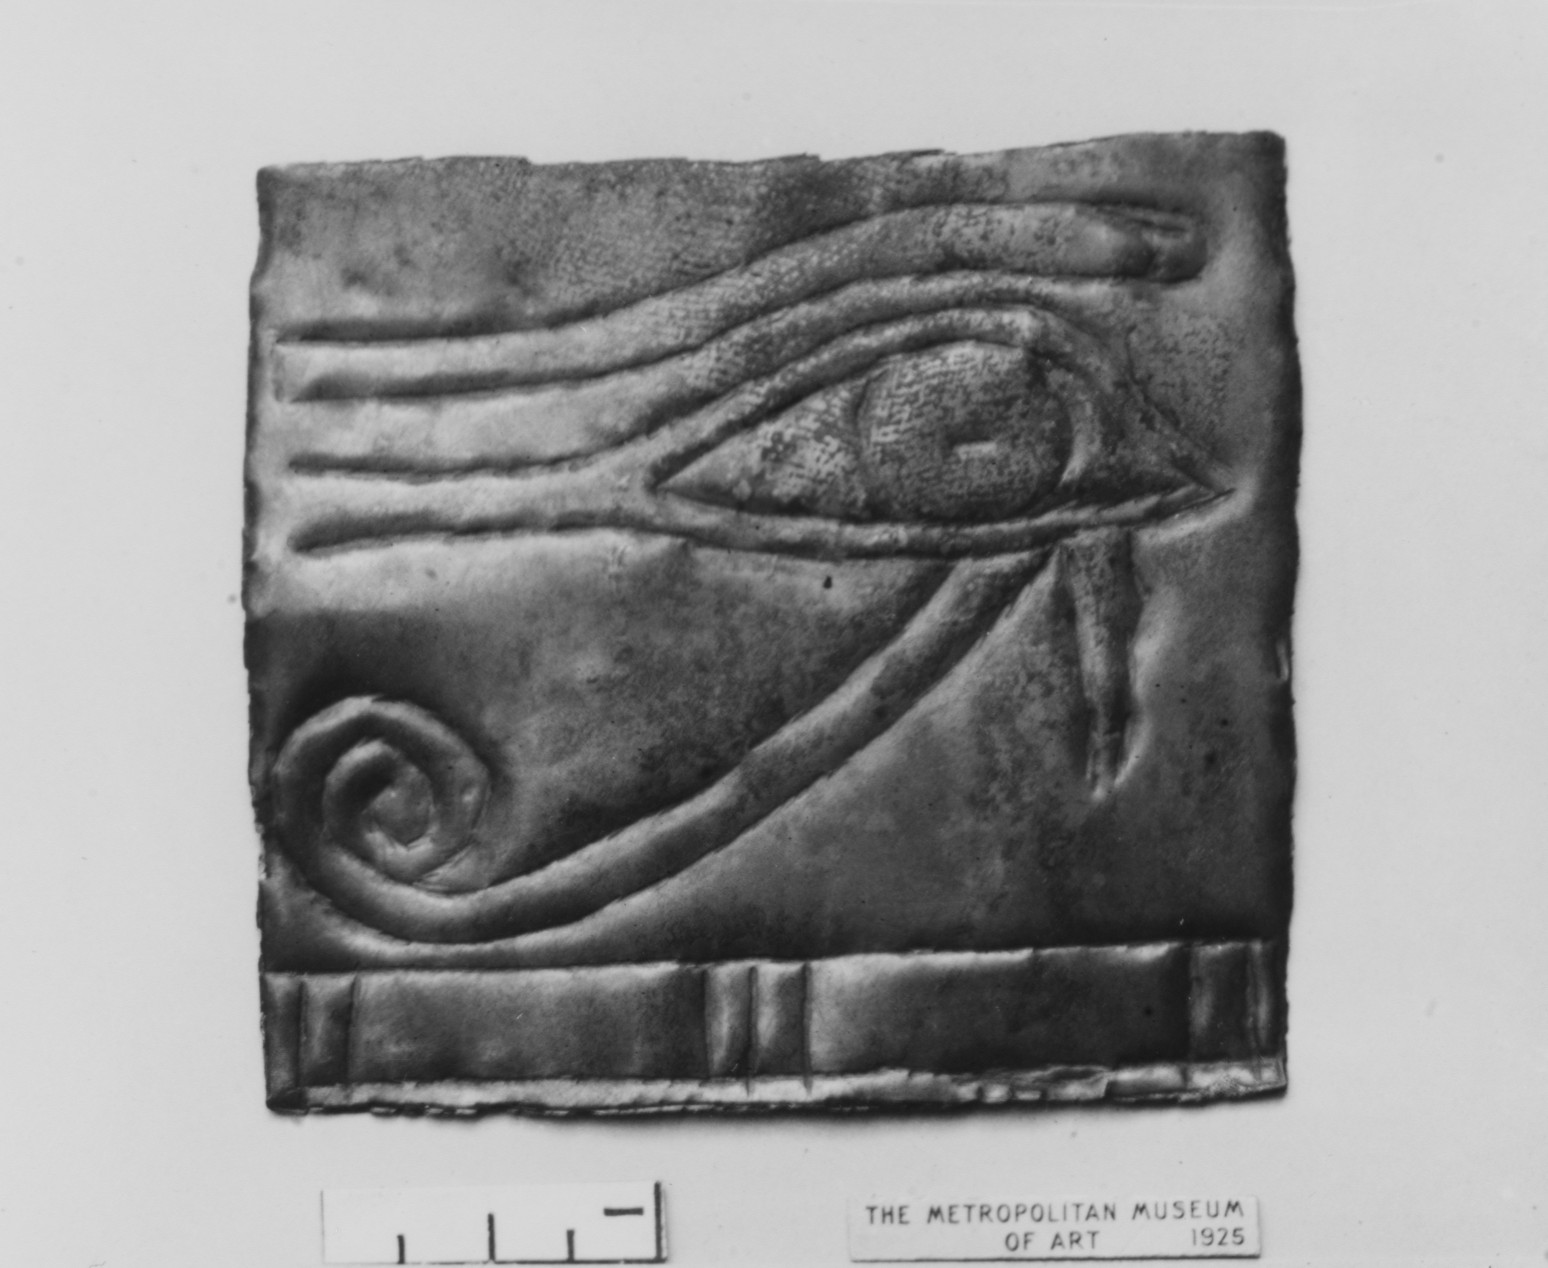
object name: amulet plaque, wedjat eye, gautsoshen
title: Wedjat Eye Incision Plaque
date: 1000-945 BCE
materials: bronze, copper alloy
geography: egypt